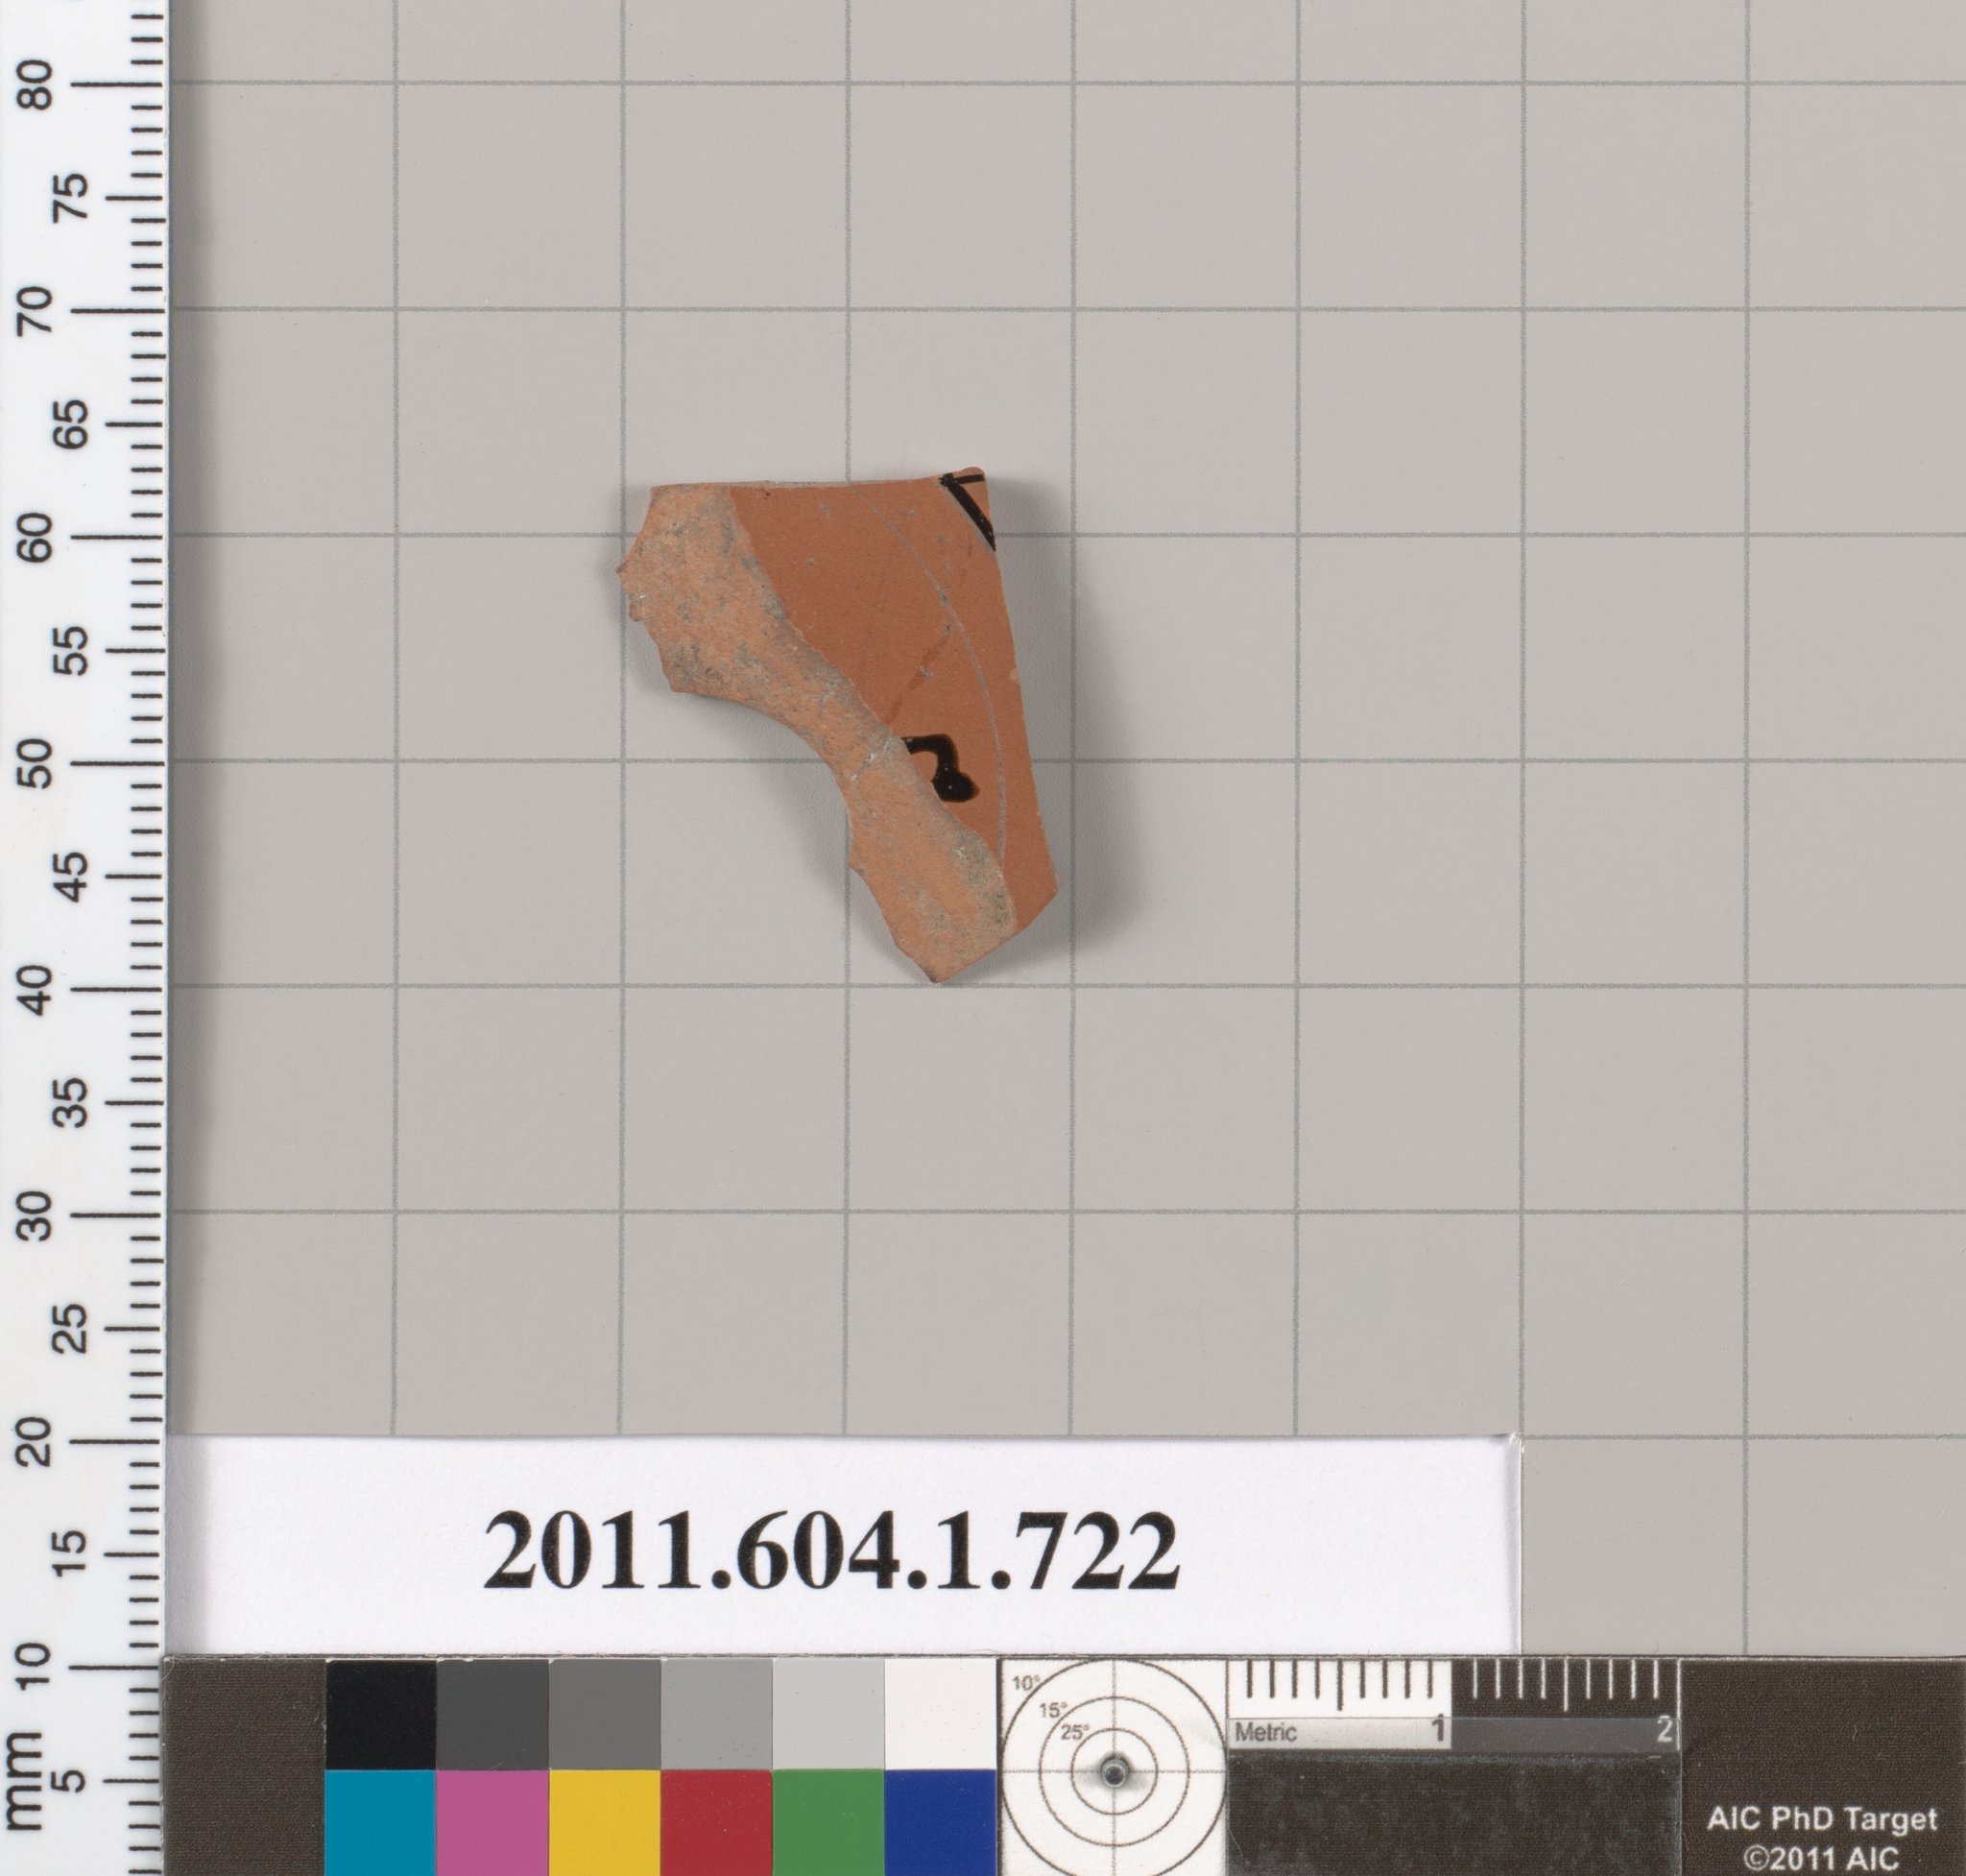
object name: kylix fragment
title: Terracotta fragment of a kylix (drinking cup)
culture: greek, attic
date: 534-468 BCE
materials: terracotta